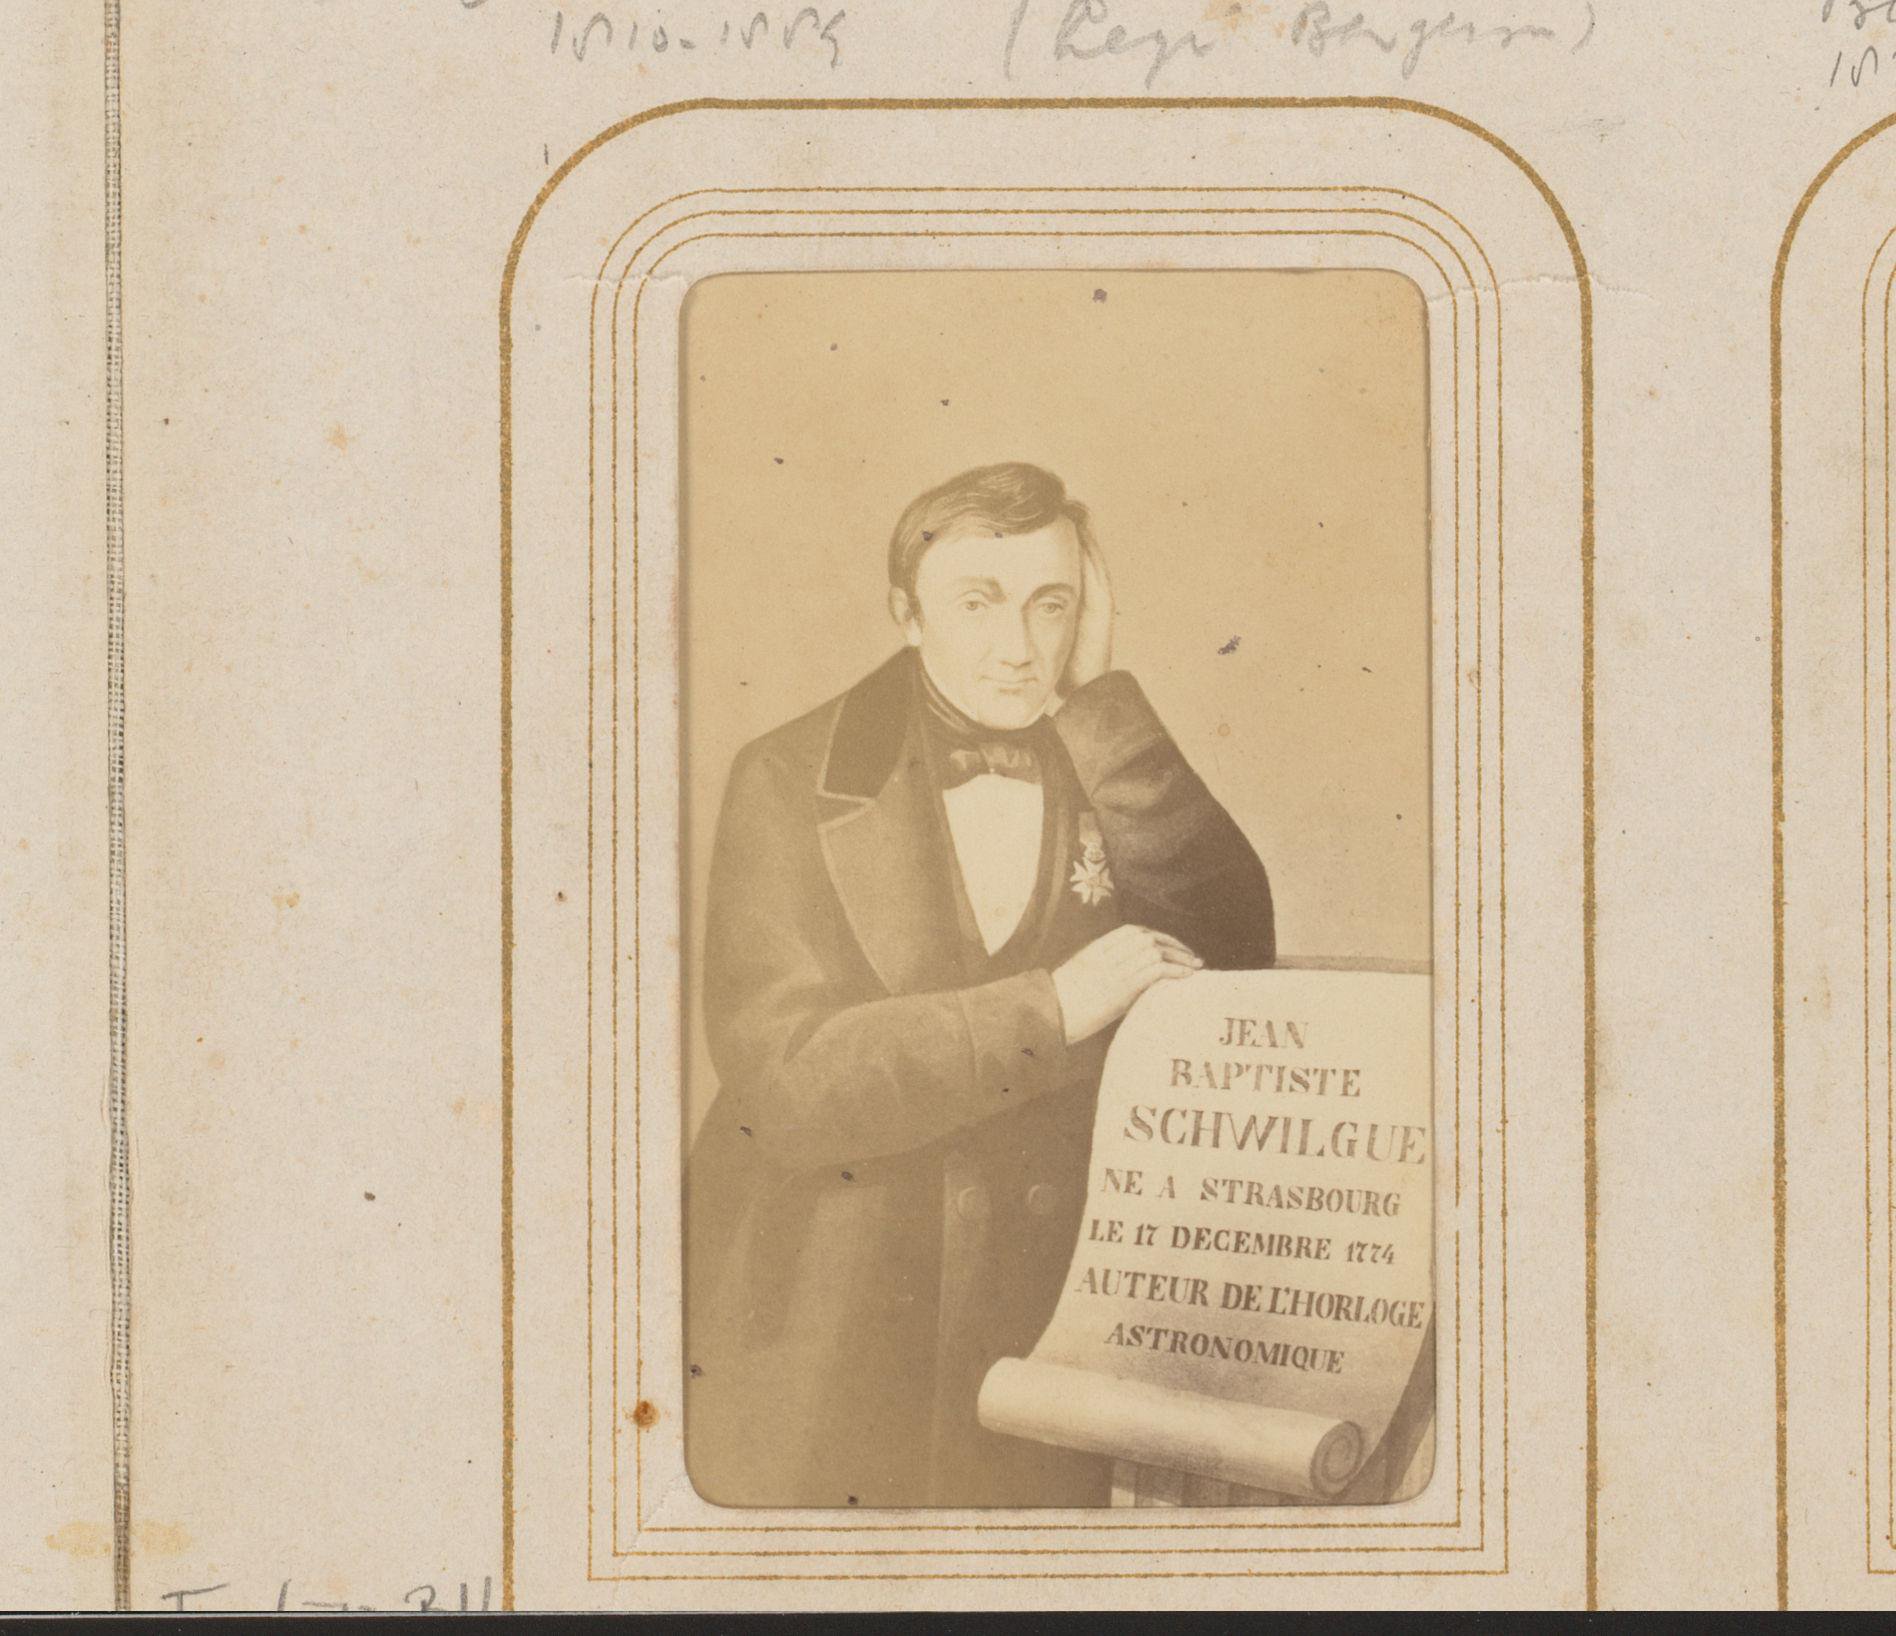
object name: reproduction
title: Fotoreproductie van een geschilderd portret van Jean-Baptiste Schwilgué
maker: Anonymous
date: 1860-1880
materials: cardboard, photographic support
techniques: albumen print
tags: historical persons, watchmaker, clockmaker